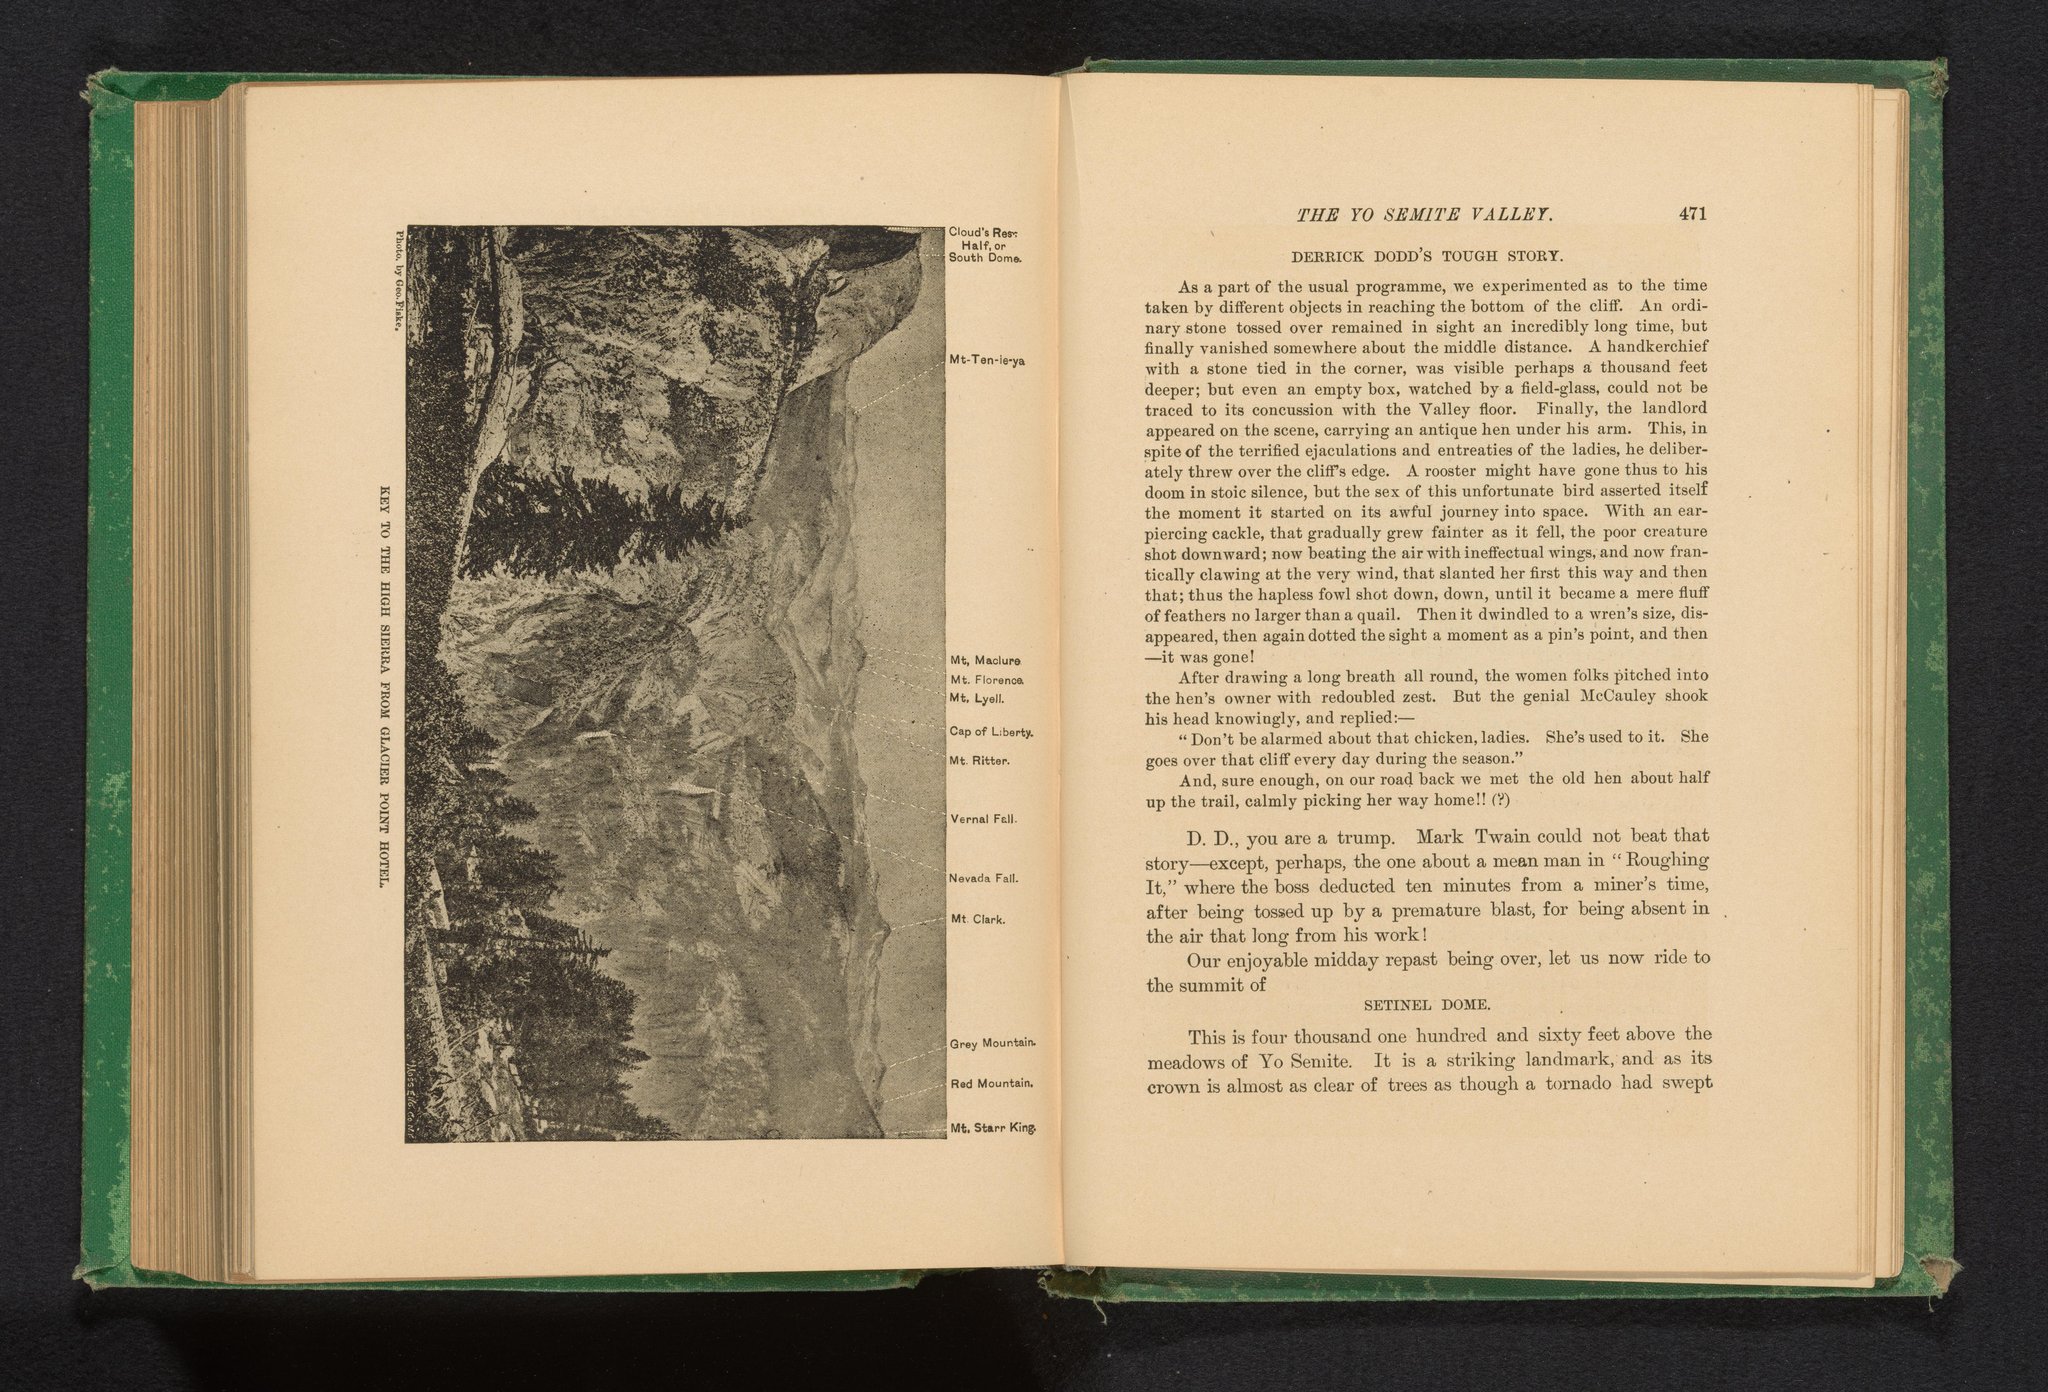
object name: photomechanical print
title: Gezicht op Sierra Nevada, Californië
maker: george fiske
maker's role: fotograaf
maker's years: 1835-1918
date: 1881-1886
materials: paper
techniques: printing block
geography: sierra nevada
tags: mountains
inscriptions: inscription: ‘Cloud's Rest/ Half, or/ South Dome./ Mt-Ten-ie-ya/ Mt. Maclure/ Mt. Florence./ Mt. Lyell./ Cap of Liberty./ Mt. Ritter./ Vernal Fall./ Nevada Fall./ Mt. Clark./ Grey Mountain./ Red Mountain./ Mt. Starr King.’